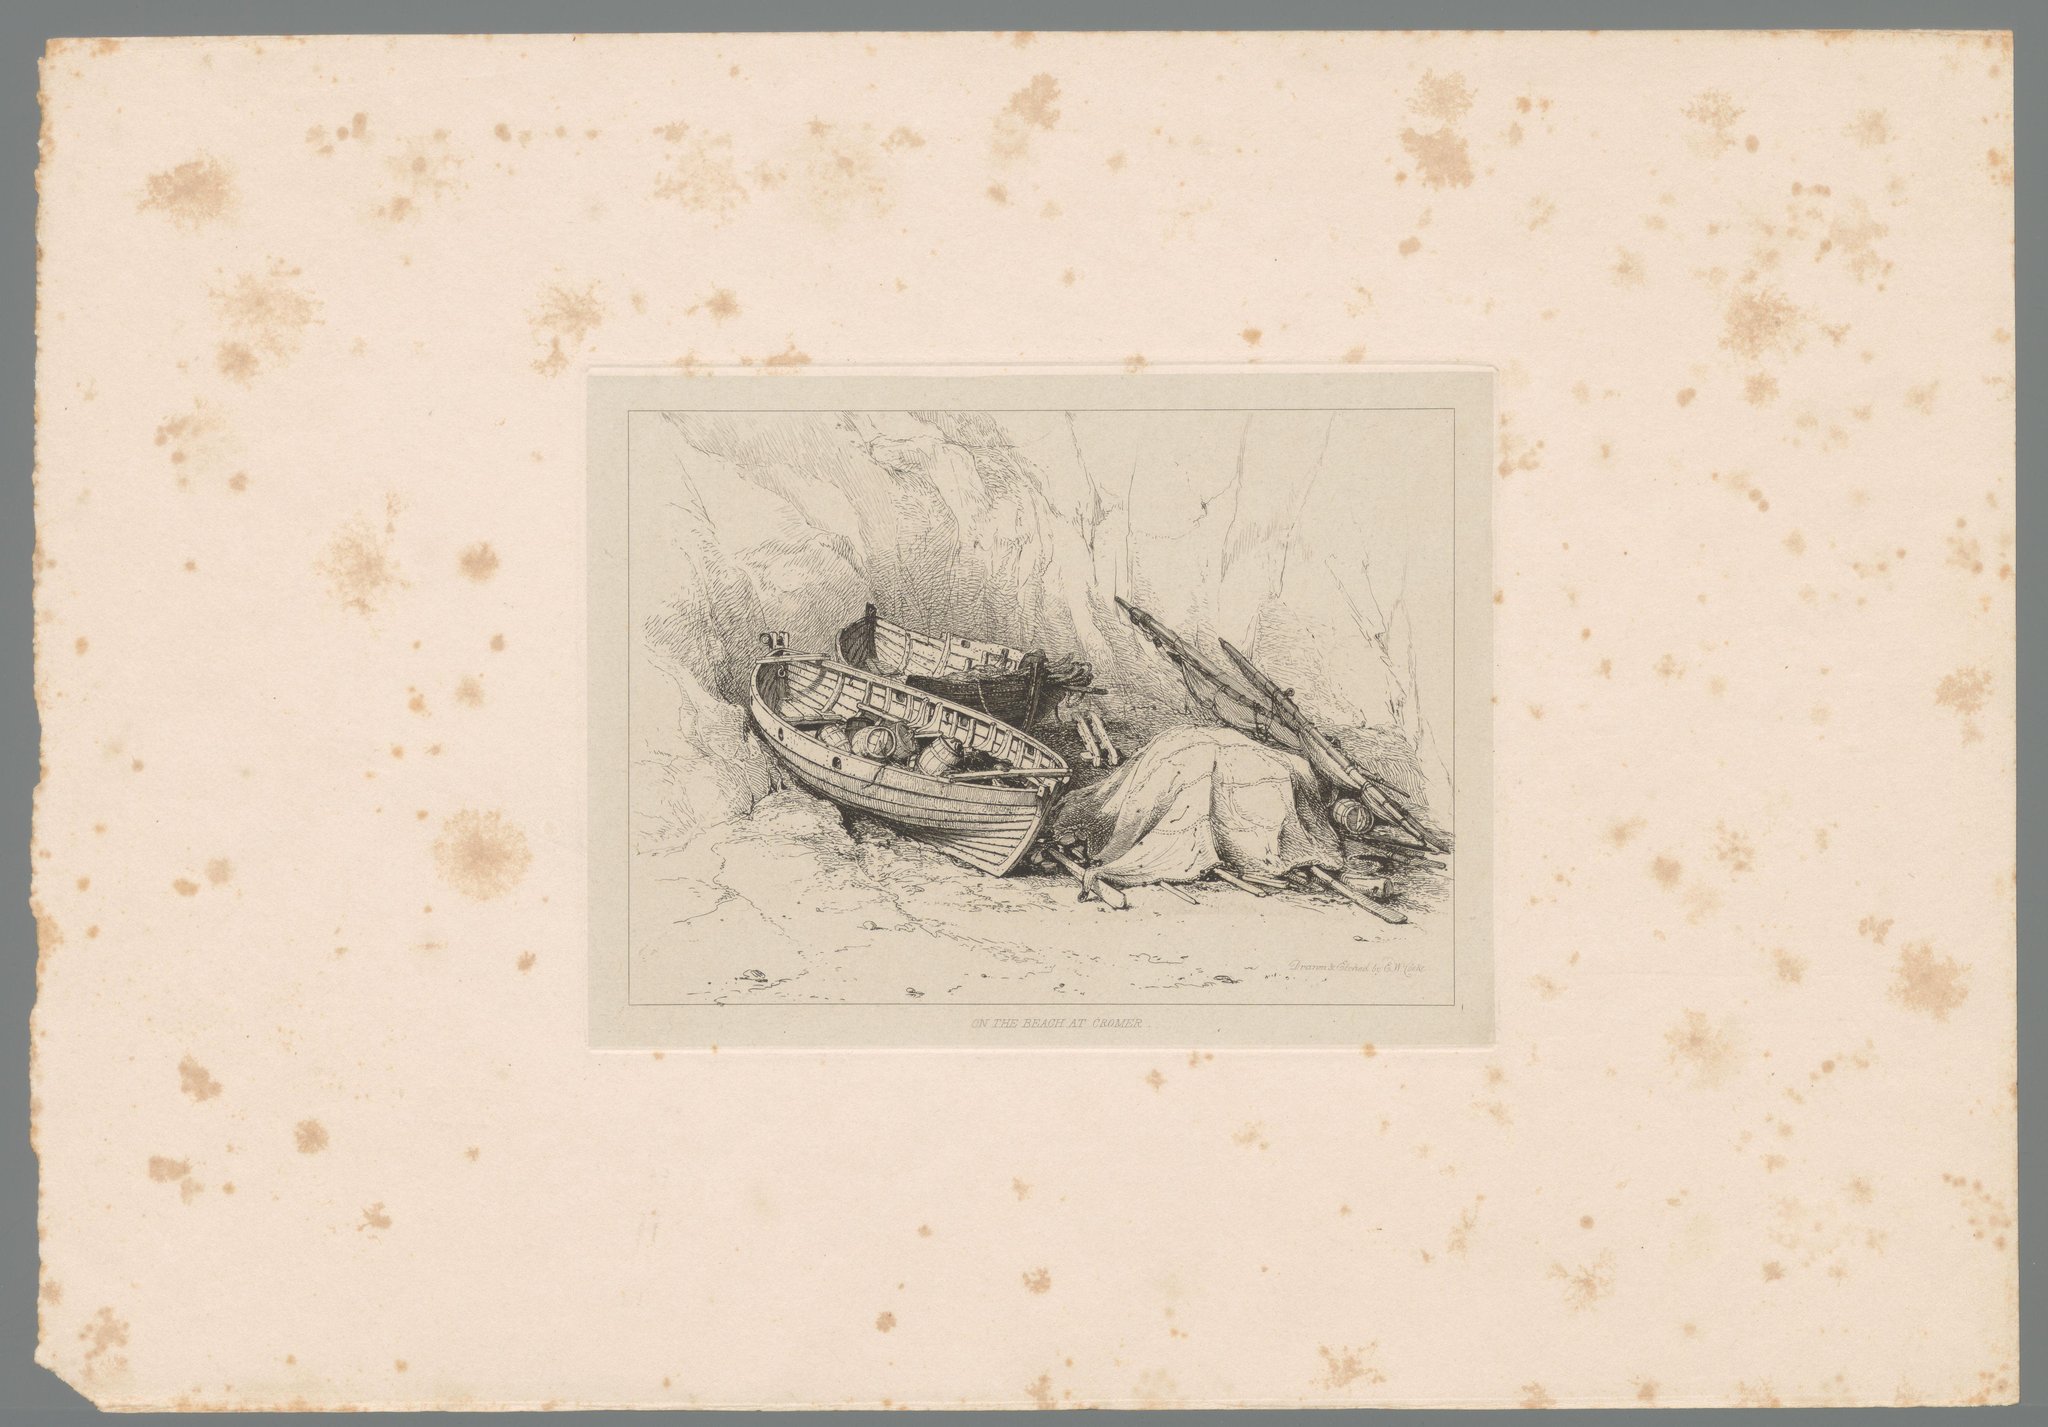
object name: print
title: Fifty Plates of Shipping and Craft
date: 1828-1829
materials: paper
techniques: etching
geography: england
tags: rowing-boat, canoe, etc., parts of ship's exterior: mast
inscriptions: collector's mark: Lugt 2165